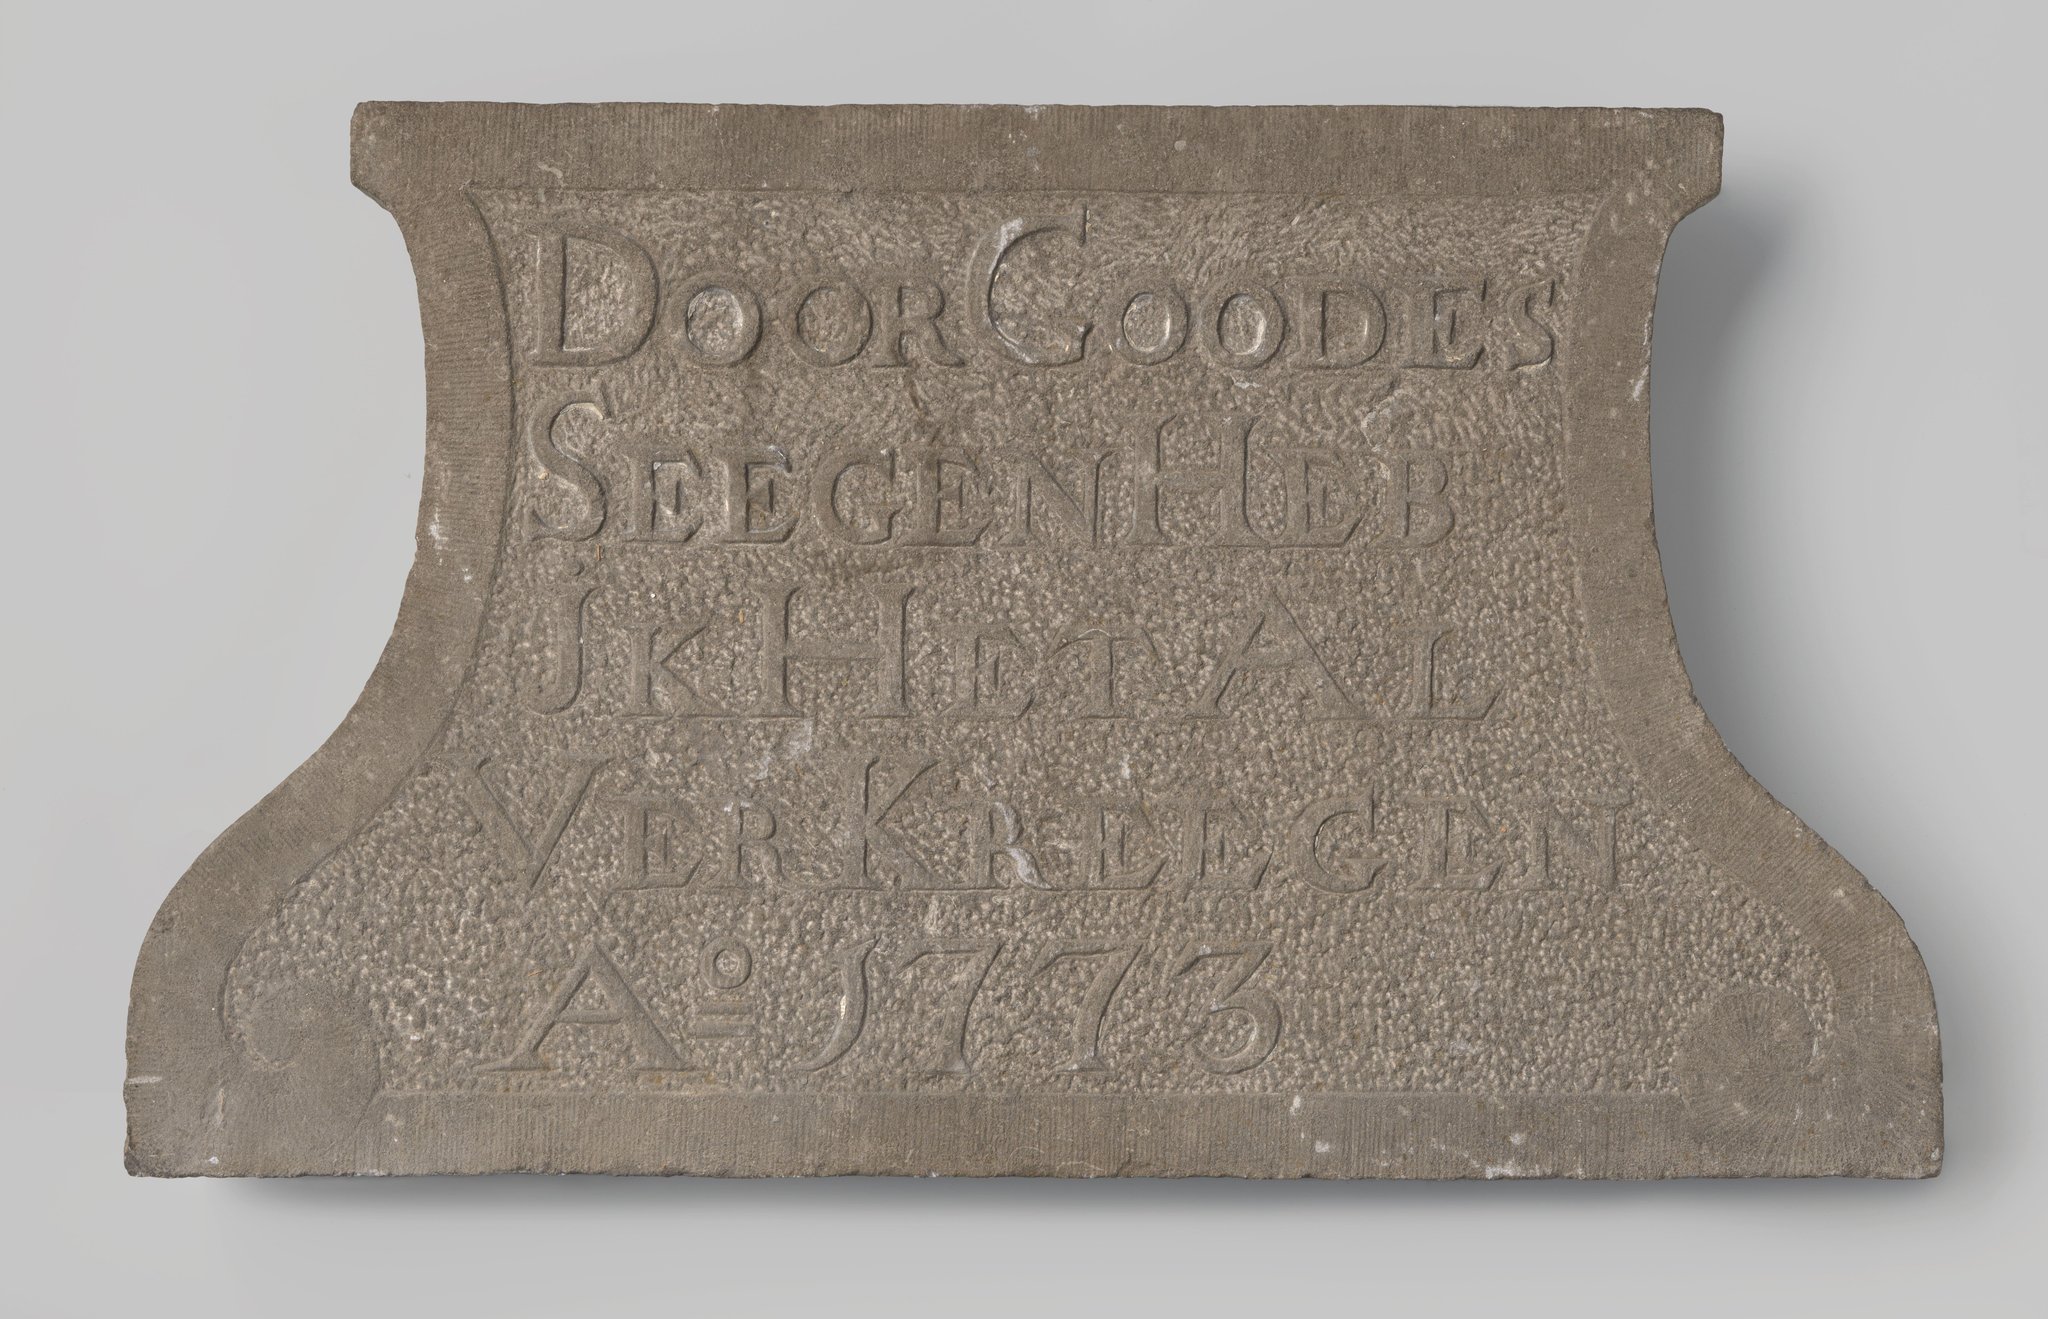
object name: gable stone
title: Gevelsteen met afbeelding van een gezenkt trapezium waarop tedkst: DOOR GOODES SEEGEN HEB IK HET AL VERKREEGEN A 1773.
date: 1773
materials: stone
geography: netherlands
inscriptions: date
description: Trapezium met ingezwenkte zijkanten, waarop de tekst DOOR GOODES SEEGEN HEB IK HET AL VERKREEGEN A 1773.